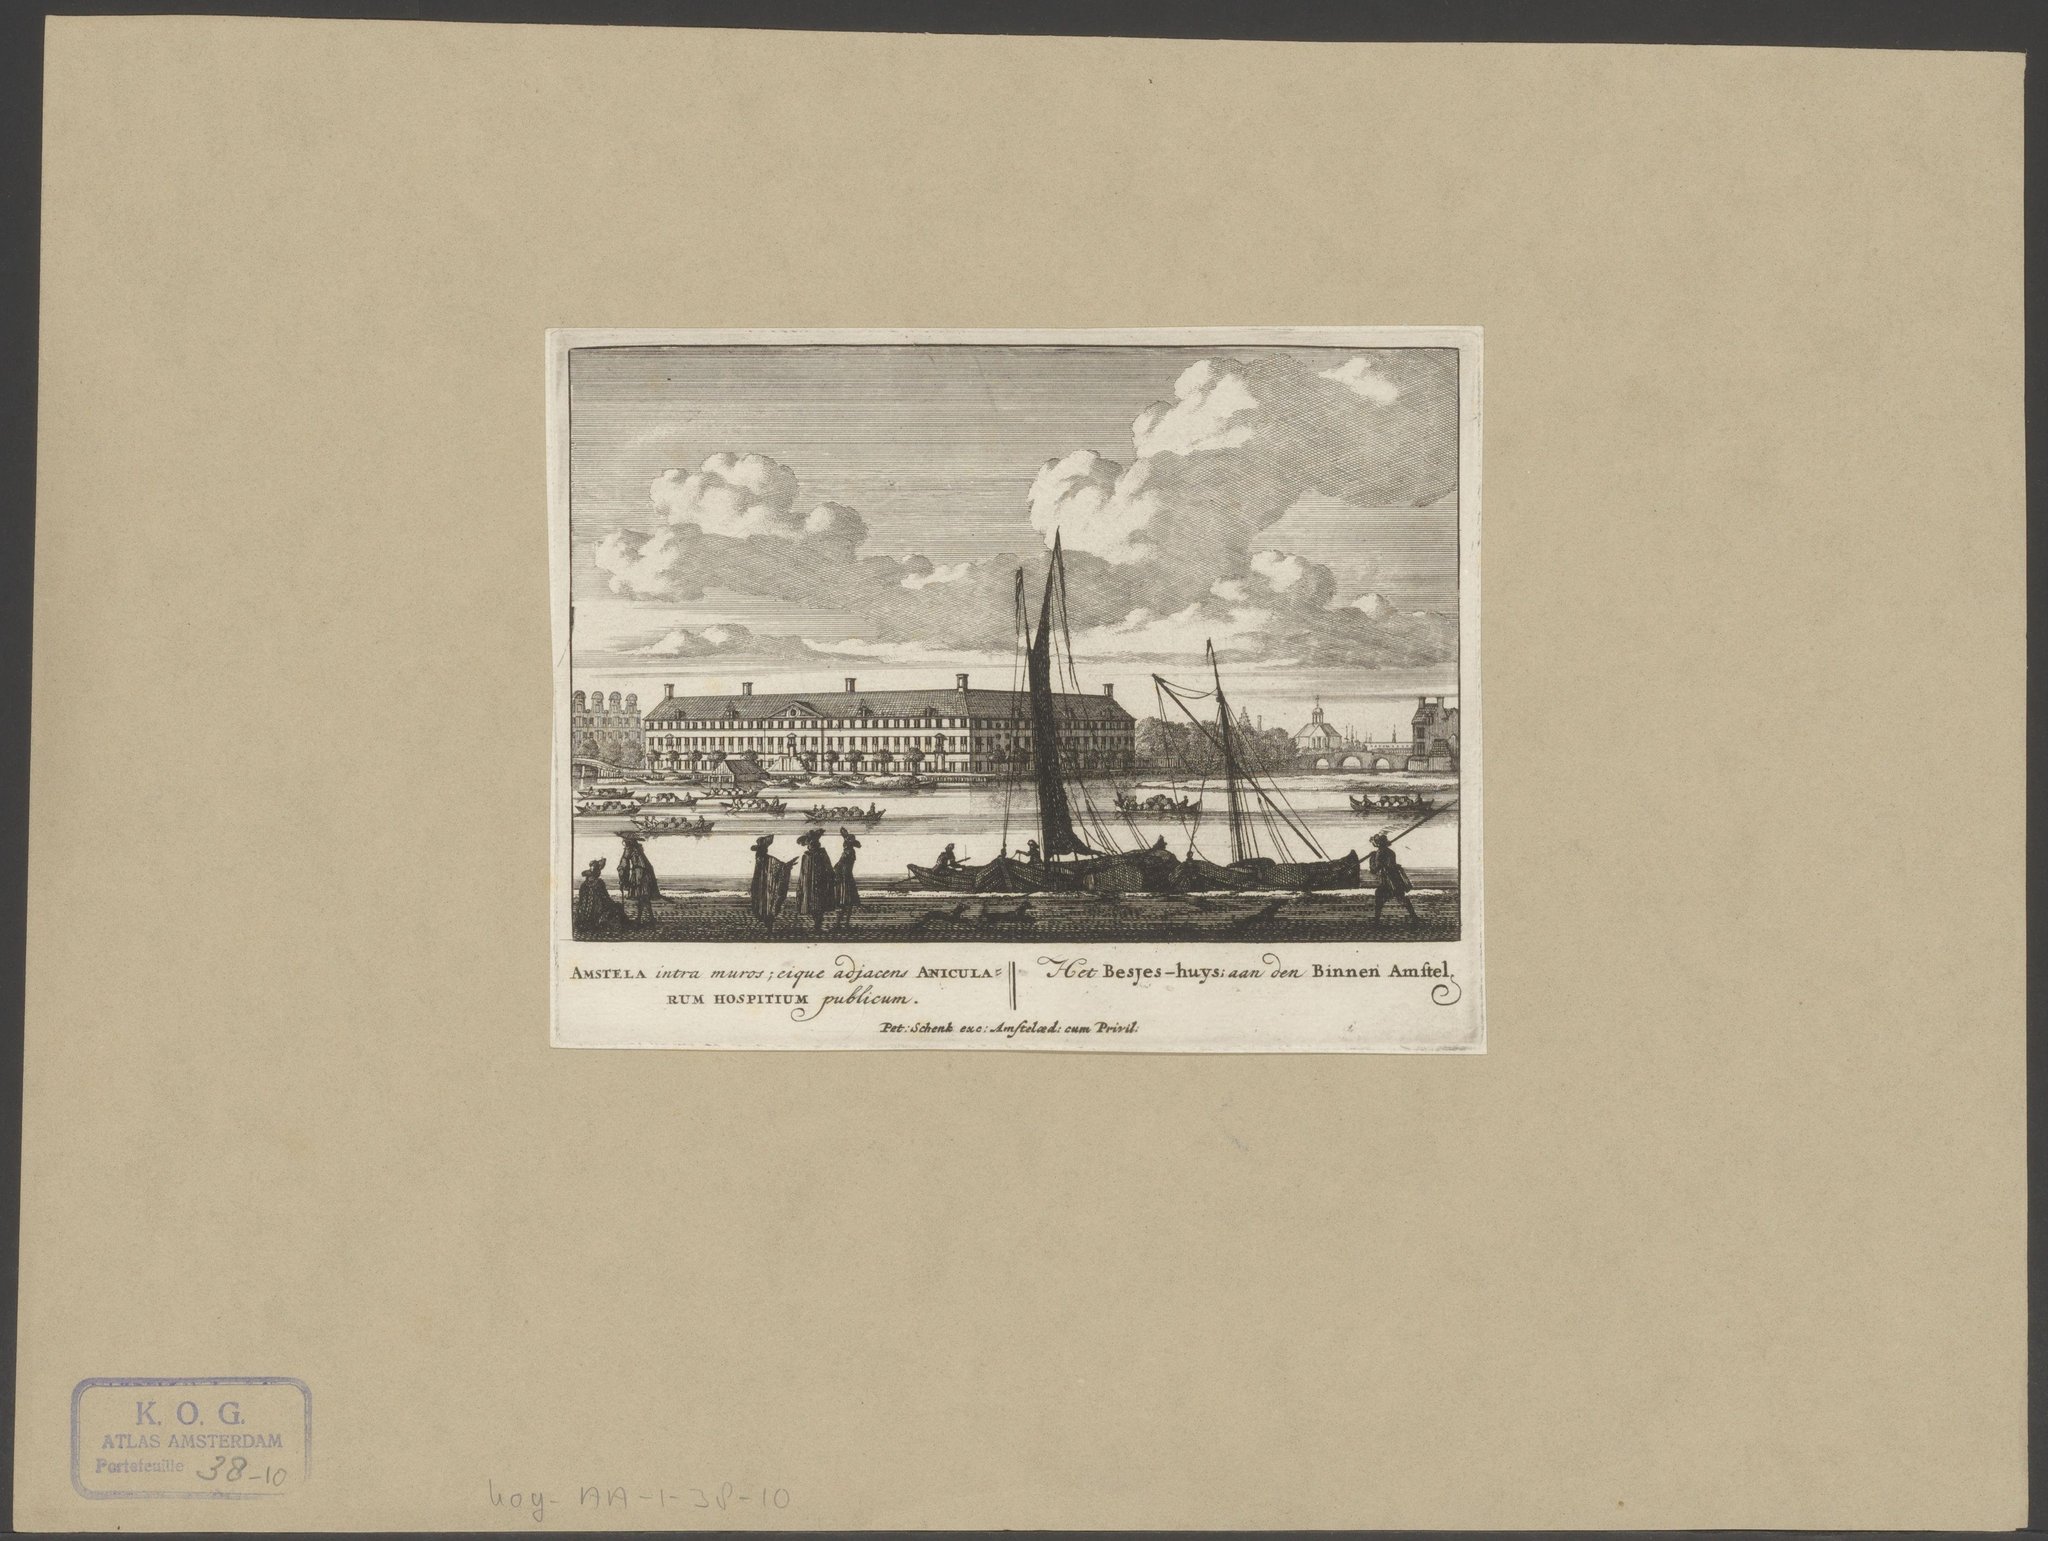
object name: print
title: Amstela intra muros; eique adjacens Anicularum Hospitium publicum / Het Besjes-huys; aan den Binnen Amstel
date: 1700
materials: paper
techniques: engraving, etching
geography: amsterdam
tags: ships (in general), canals, waters (in city) (+ city(-scape) with figures, staffage), old-people's home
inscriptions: collector's mark: Lugt 1641b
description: Onderwerpsrubriek binnen de Atlas Amsterdam: Armwezen en liefdadige instellingen: II. Kerkelijke inrichtingen: Diaconie Oude Mannen- en Vrouwenhuis der Ned. Herv. Gem.